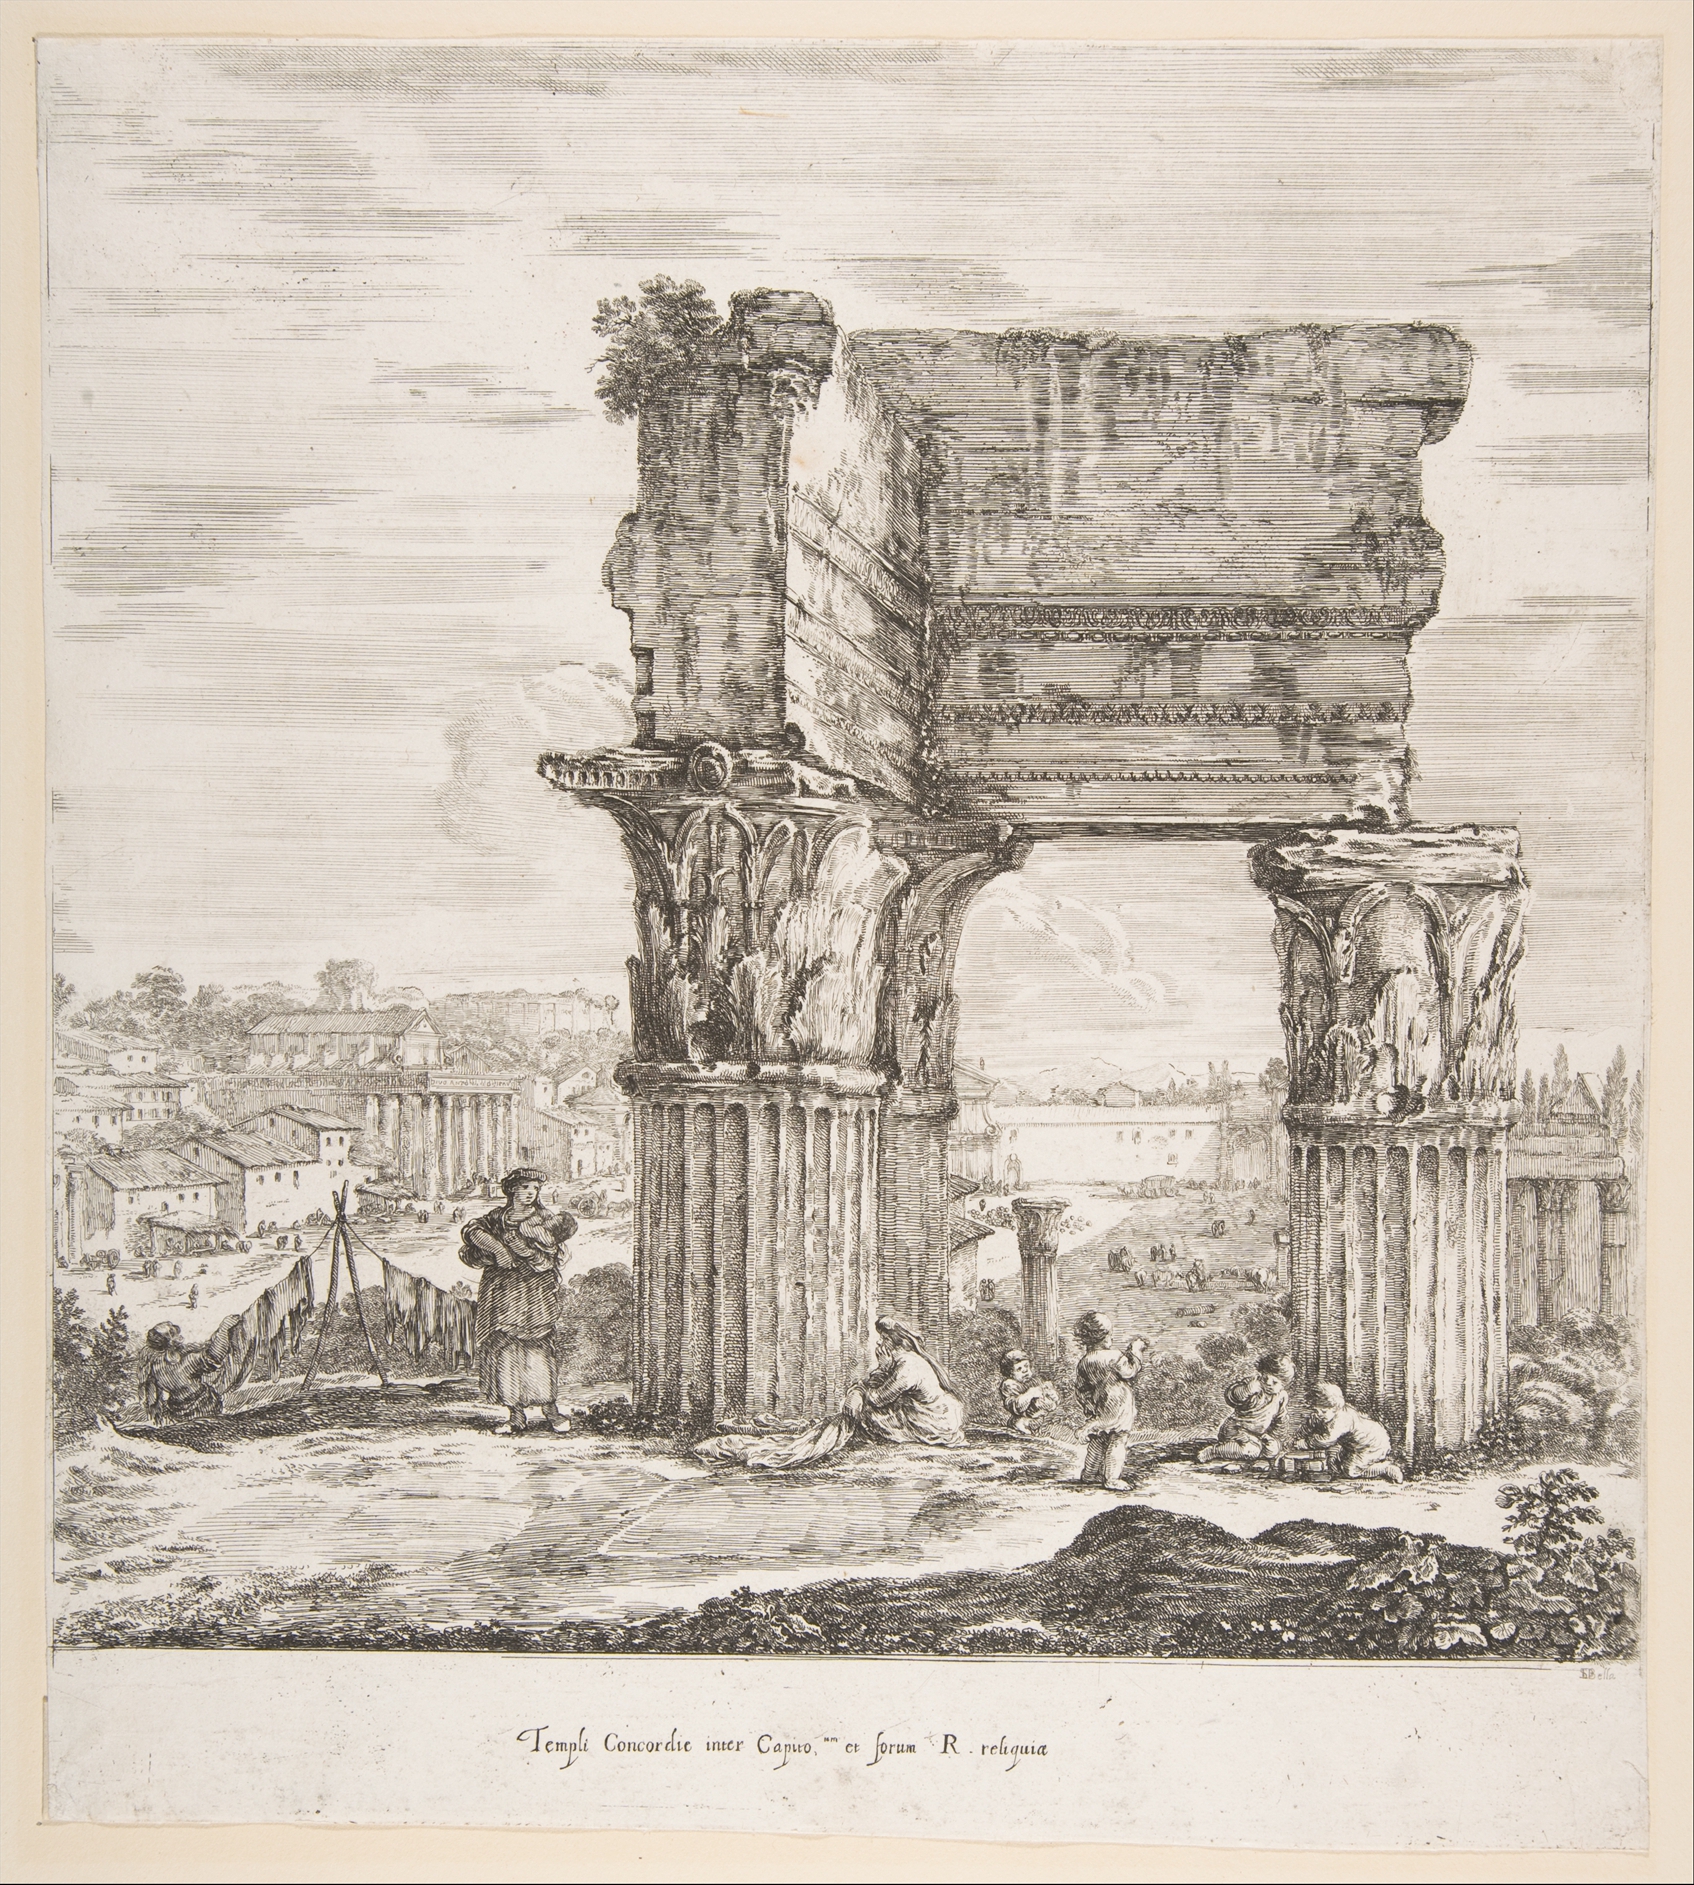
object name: print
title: The Temple of Vespasian and the Roman Forum, from "Six large views, four of Rome, and two of the Roman countryside" (Six grandes vues, dont quatre de Rome et deux de la Campagne romaine)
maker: stefano della bella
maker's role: artist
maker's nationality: italian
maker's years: 1610-1664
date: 1656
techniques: etching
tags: human figures,ruins